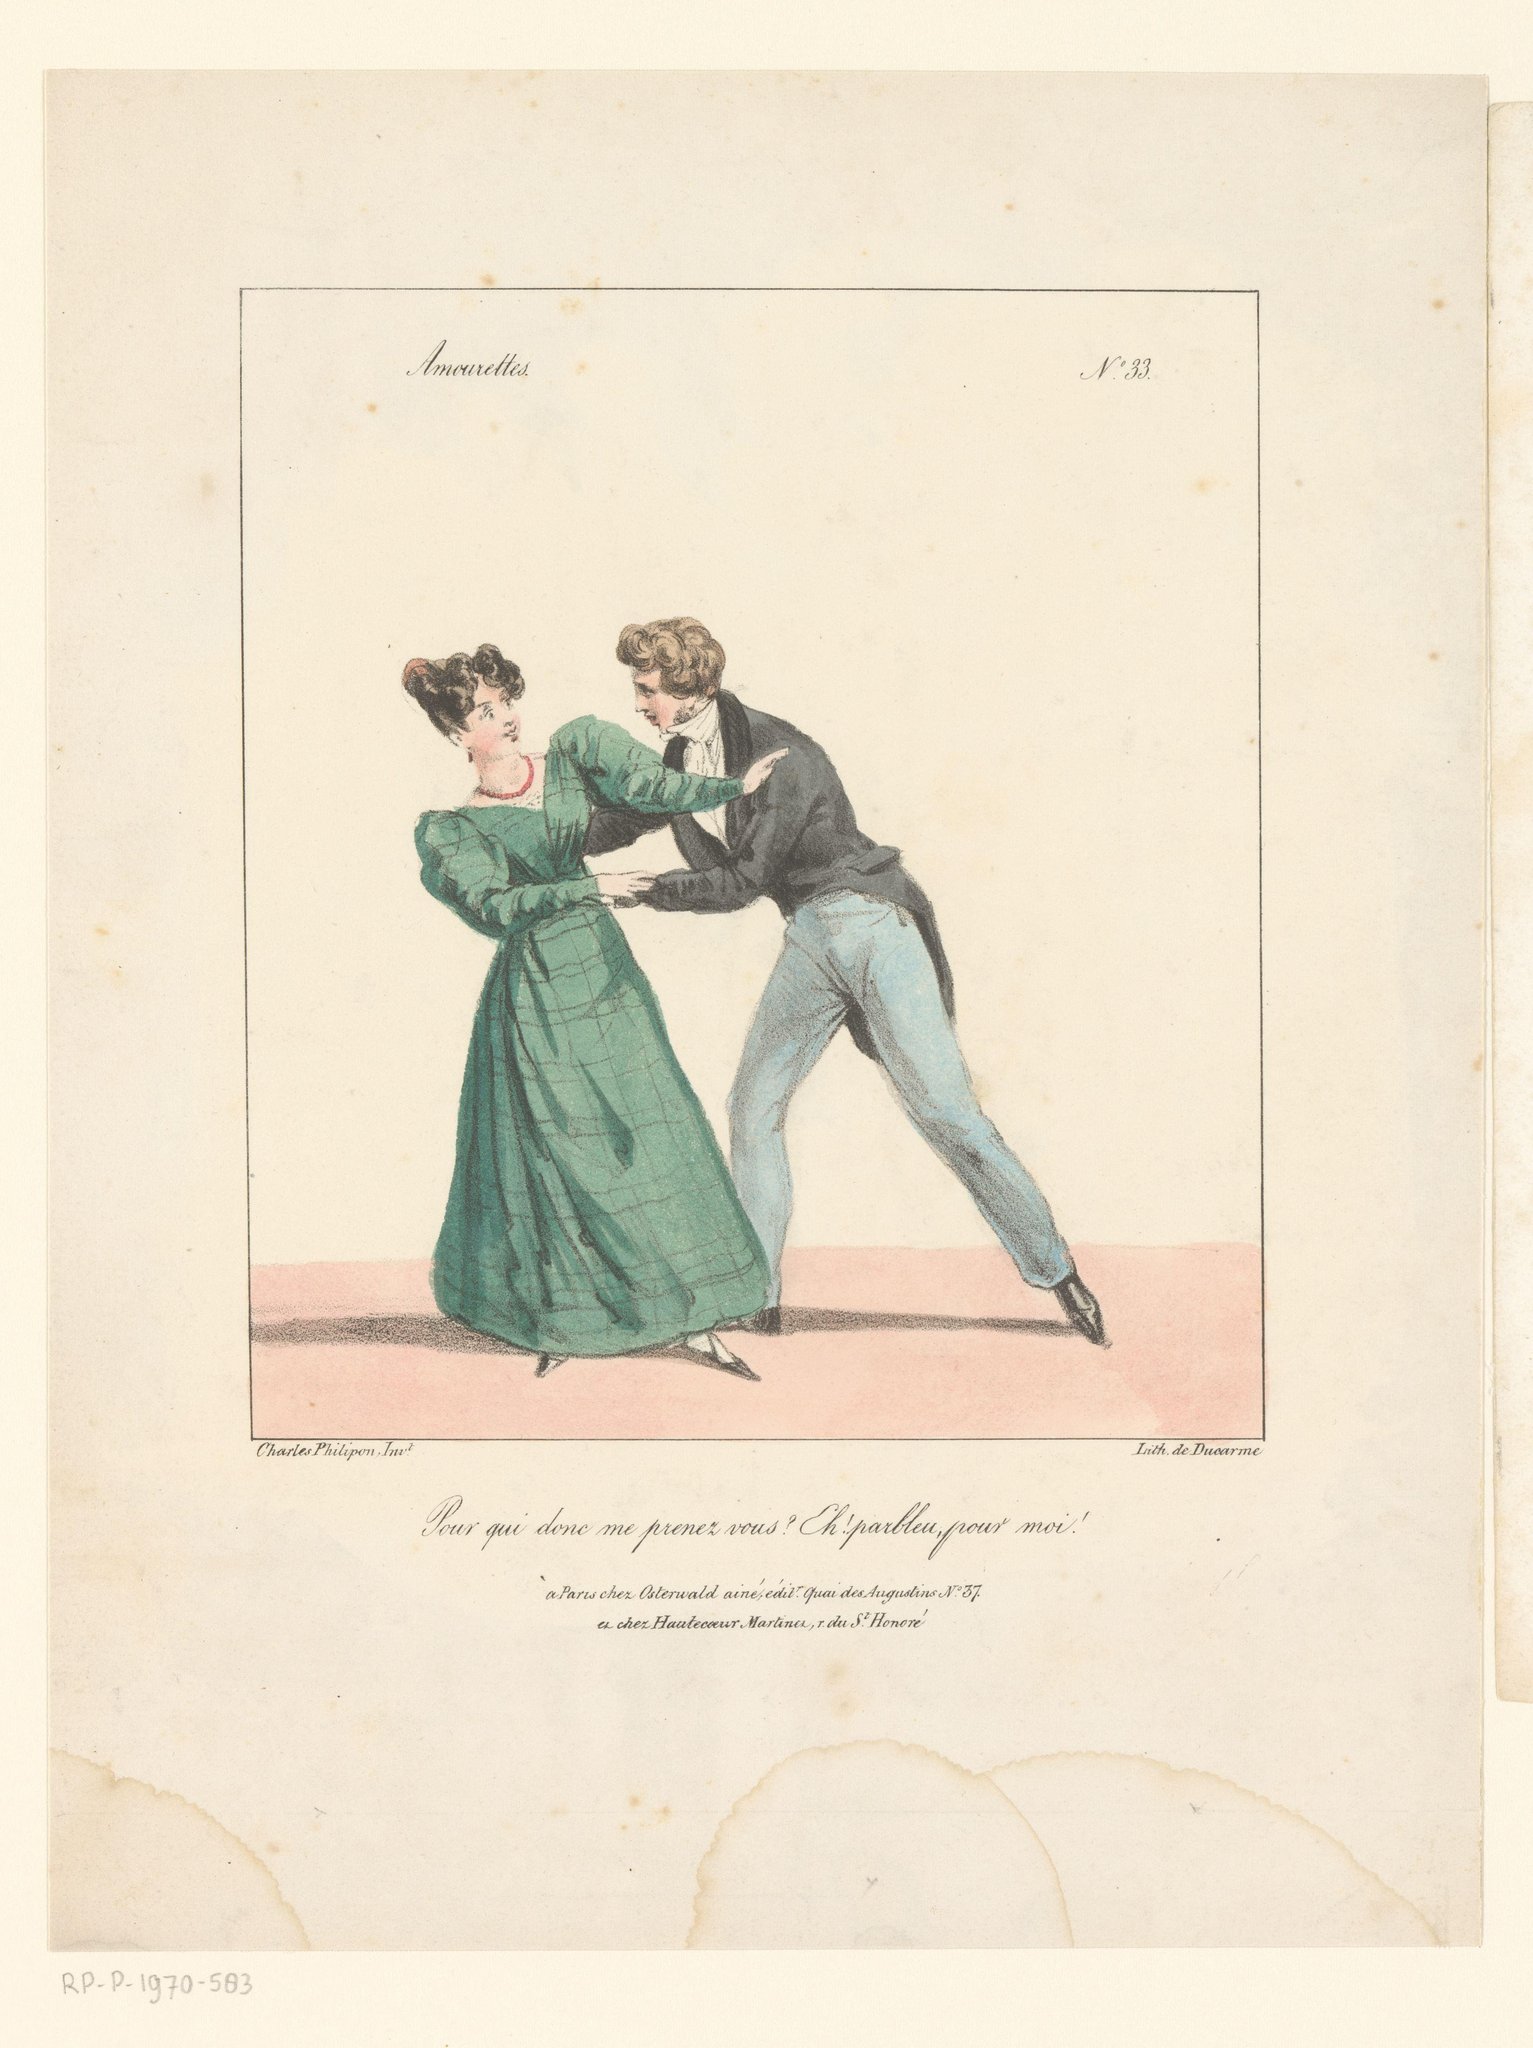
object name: print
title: Man probeert vrouw het hof te maken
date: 1827-1829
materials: paper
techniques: hand coloring, lithograph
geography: paris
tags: adult woman, adult man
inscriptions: collector's mark: Lugt 2228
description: Serie bestond in eerste instantie uit achttien prenten maar is later uitgebreid, onduidelijk naar hoeveel prenten precies.